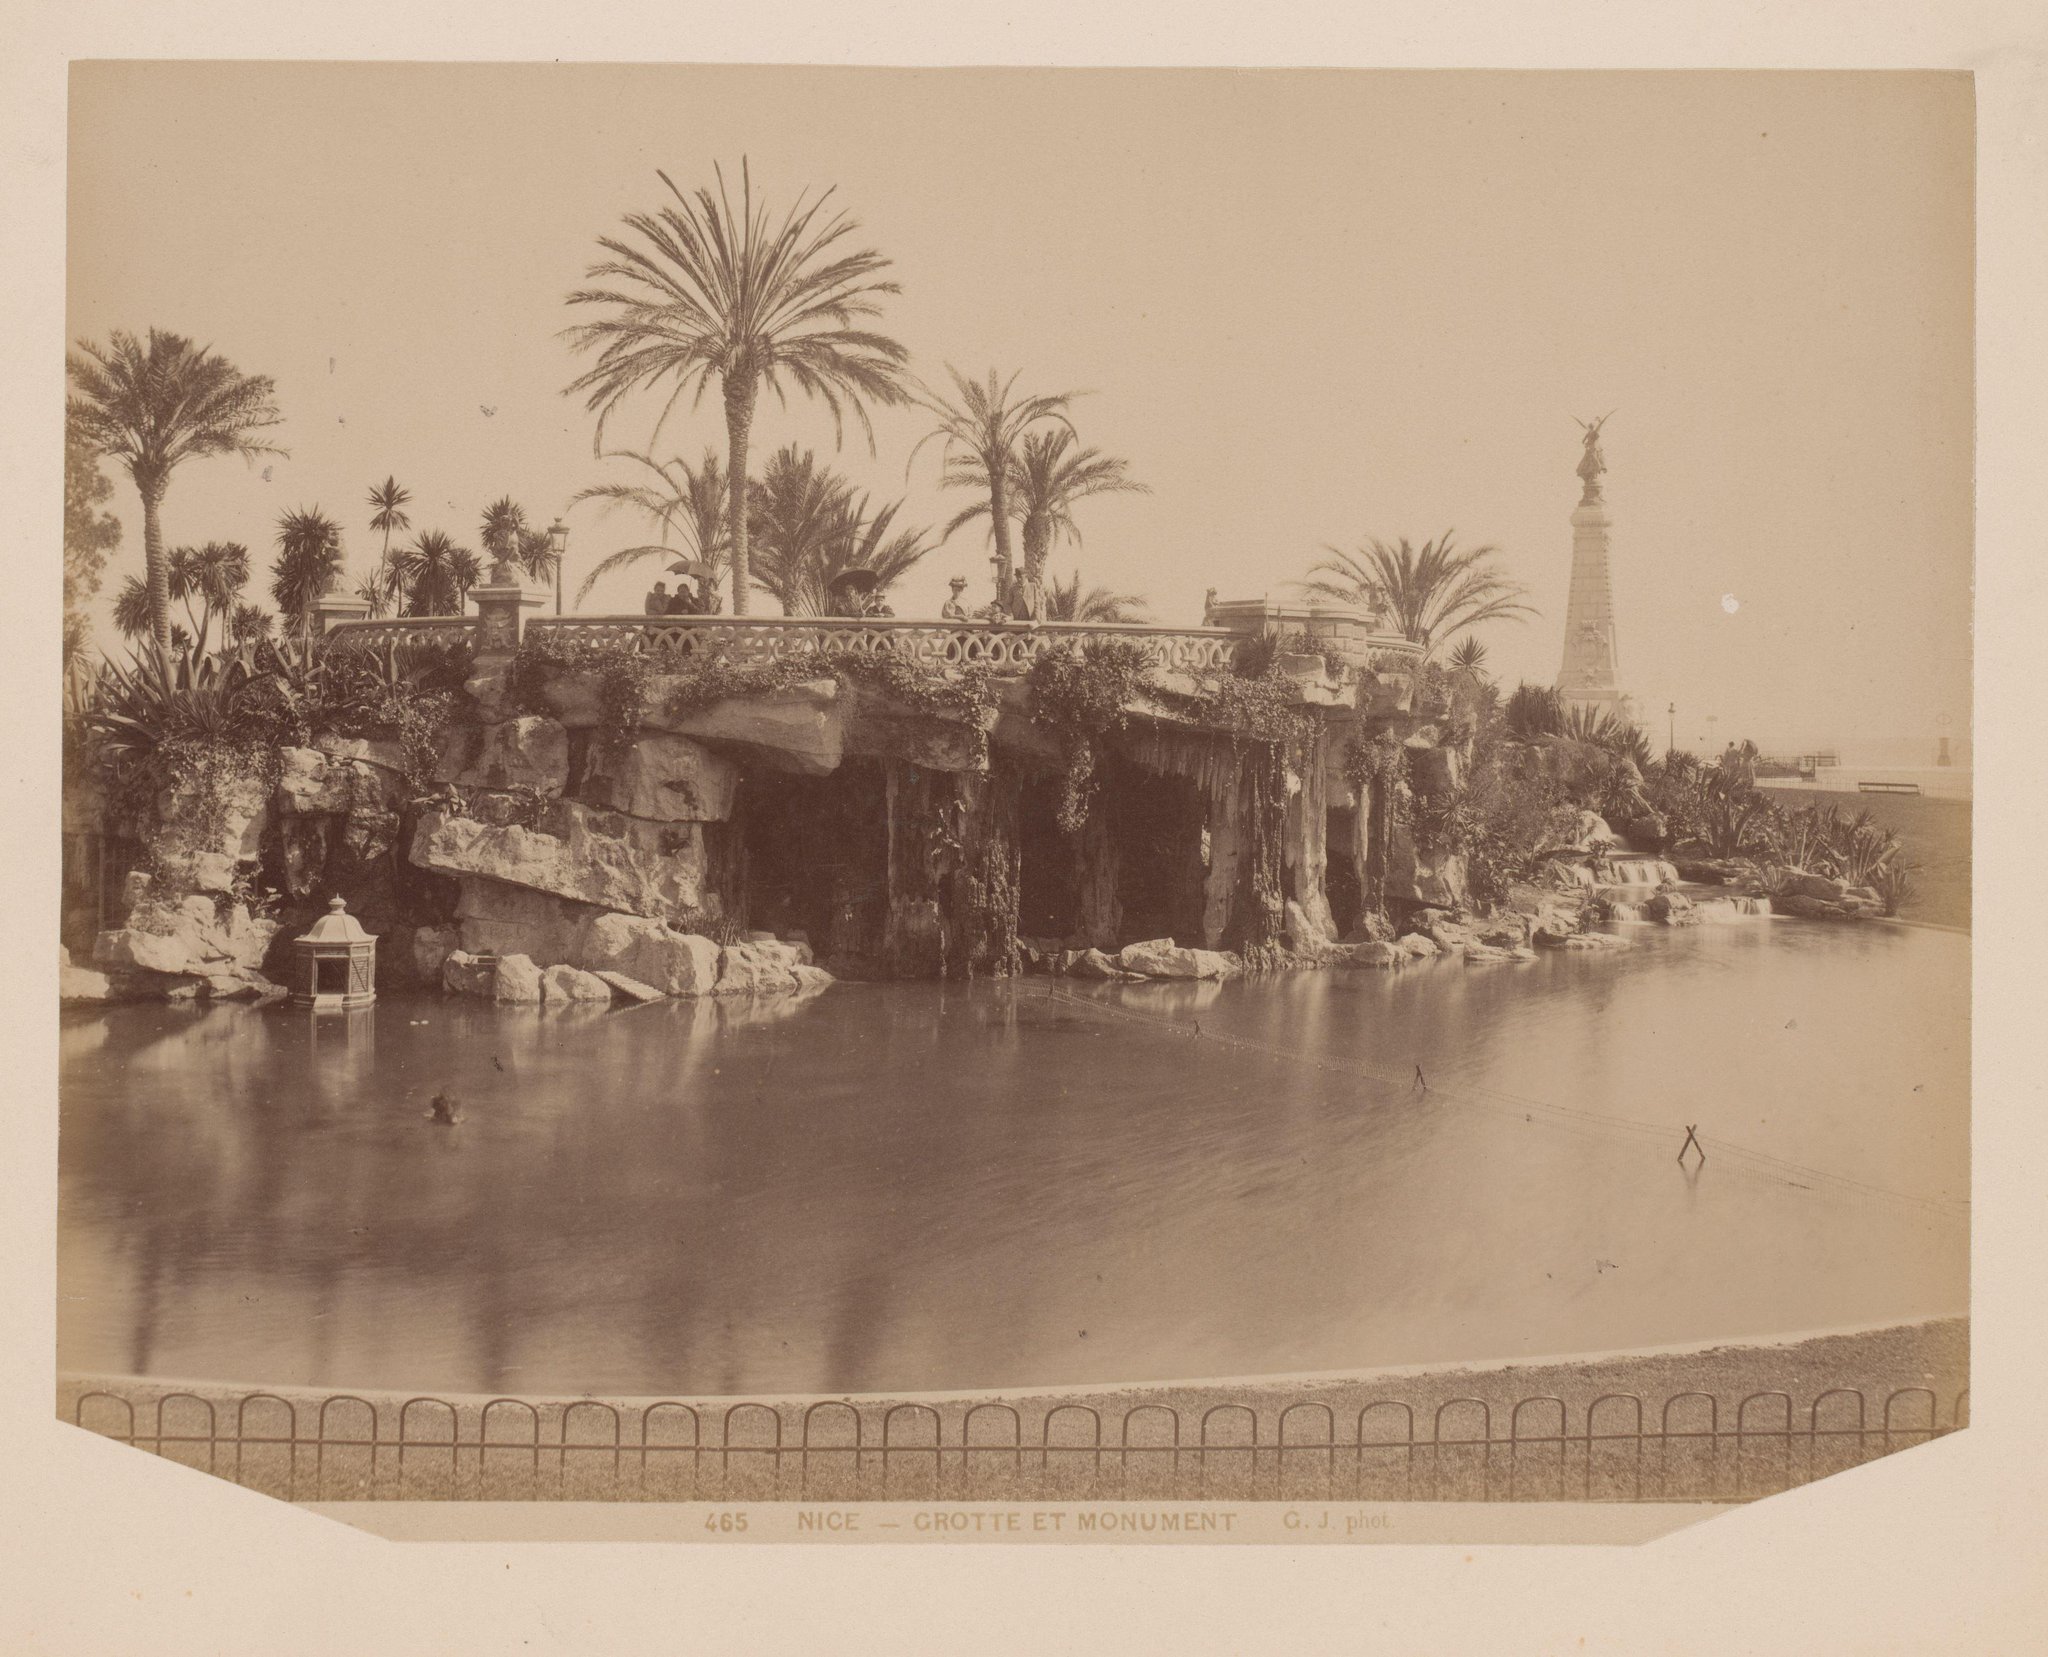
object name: photograph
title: Grotte et Monument, Nice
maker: jean gilletta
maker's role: fotograaf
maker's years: 1856-1933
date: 1896-1900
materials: cardboard, photographic support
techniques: albumen print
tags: nice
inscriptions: inscription: ‘465 NICE - GROTTE ET MONUMENT’, inscription: ‘G.J. phot.’